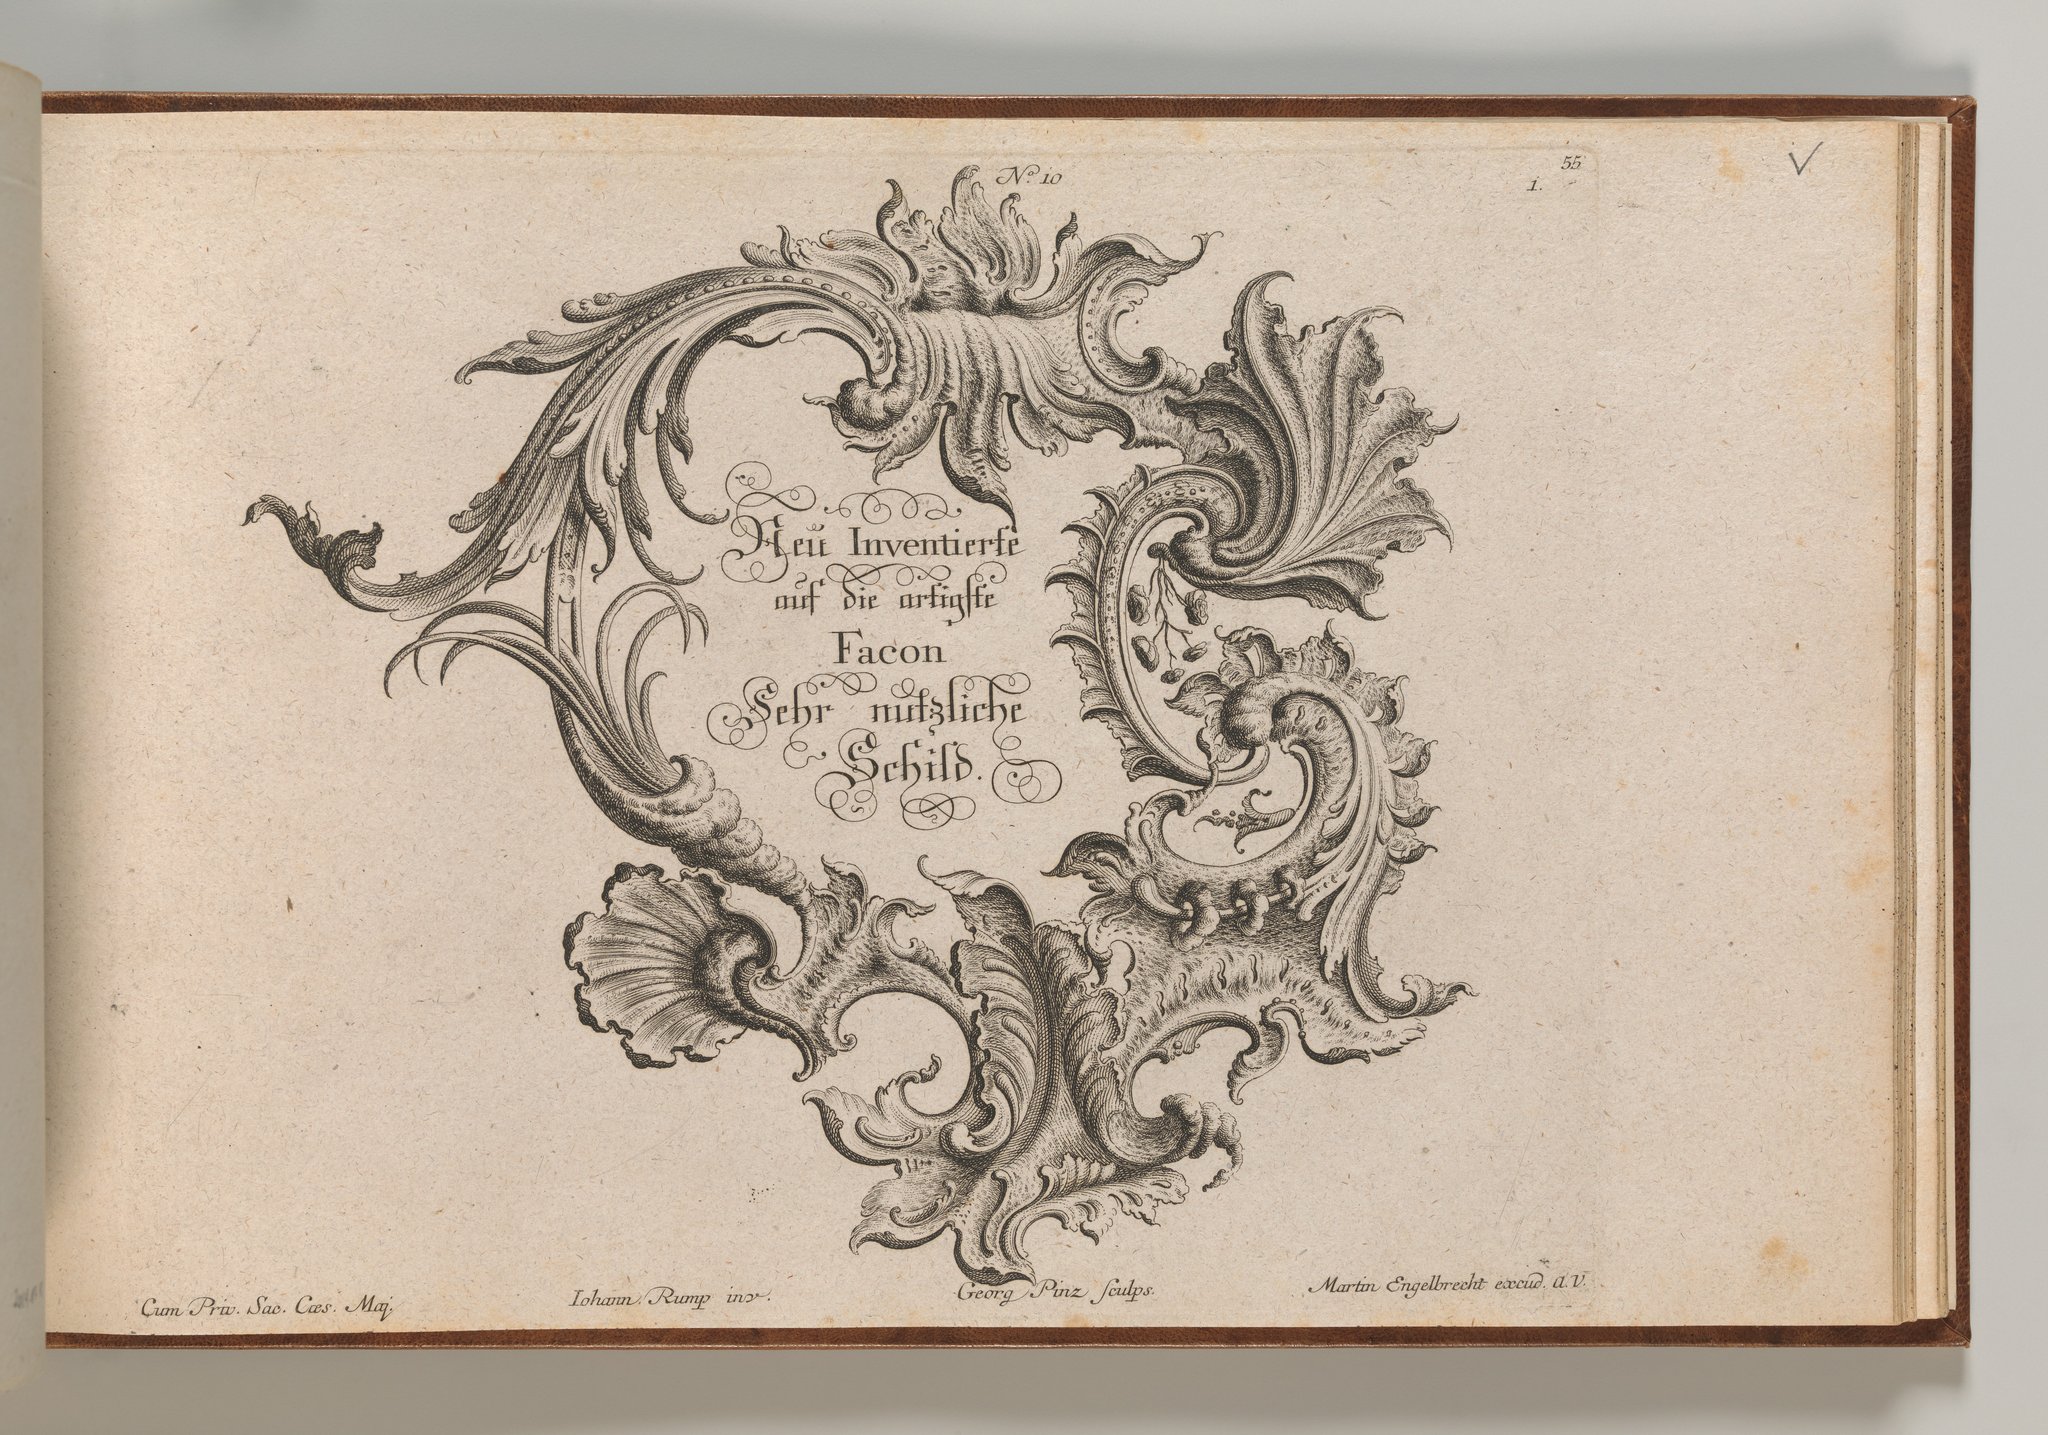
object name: album print ornament architecture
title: Design for a Cartouche, Plate 1 from 'Neu Inventierte auf die artigste Facon Sehr nutzliche Schild.'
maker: johann georg pintz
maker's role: engraver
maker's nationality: central european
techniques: etching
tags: cartouches,ornament